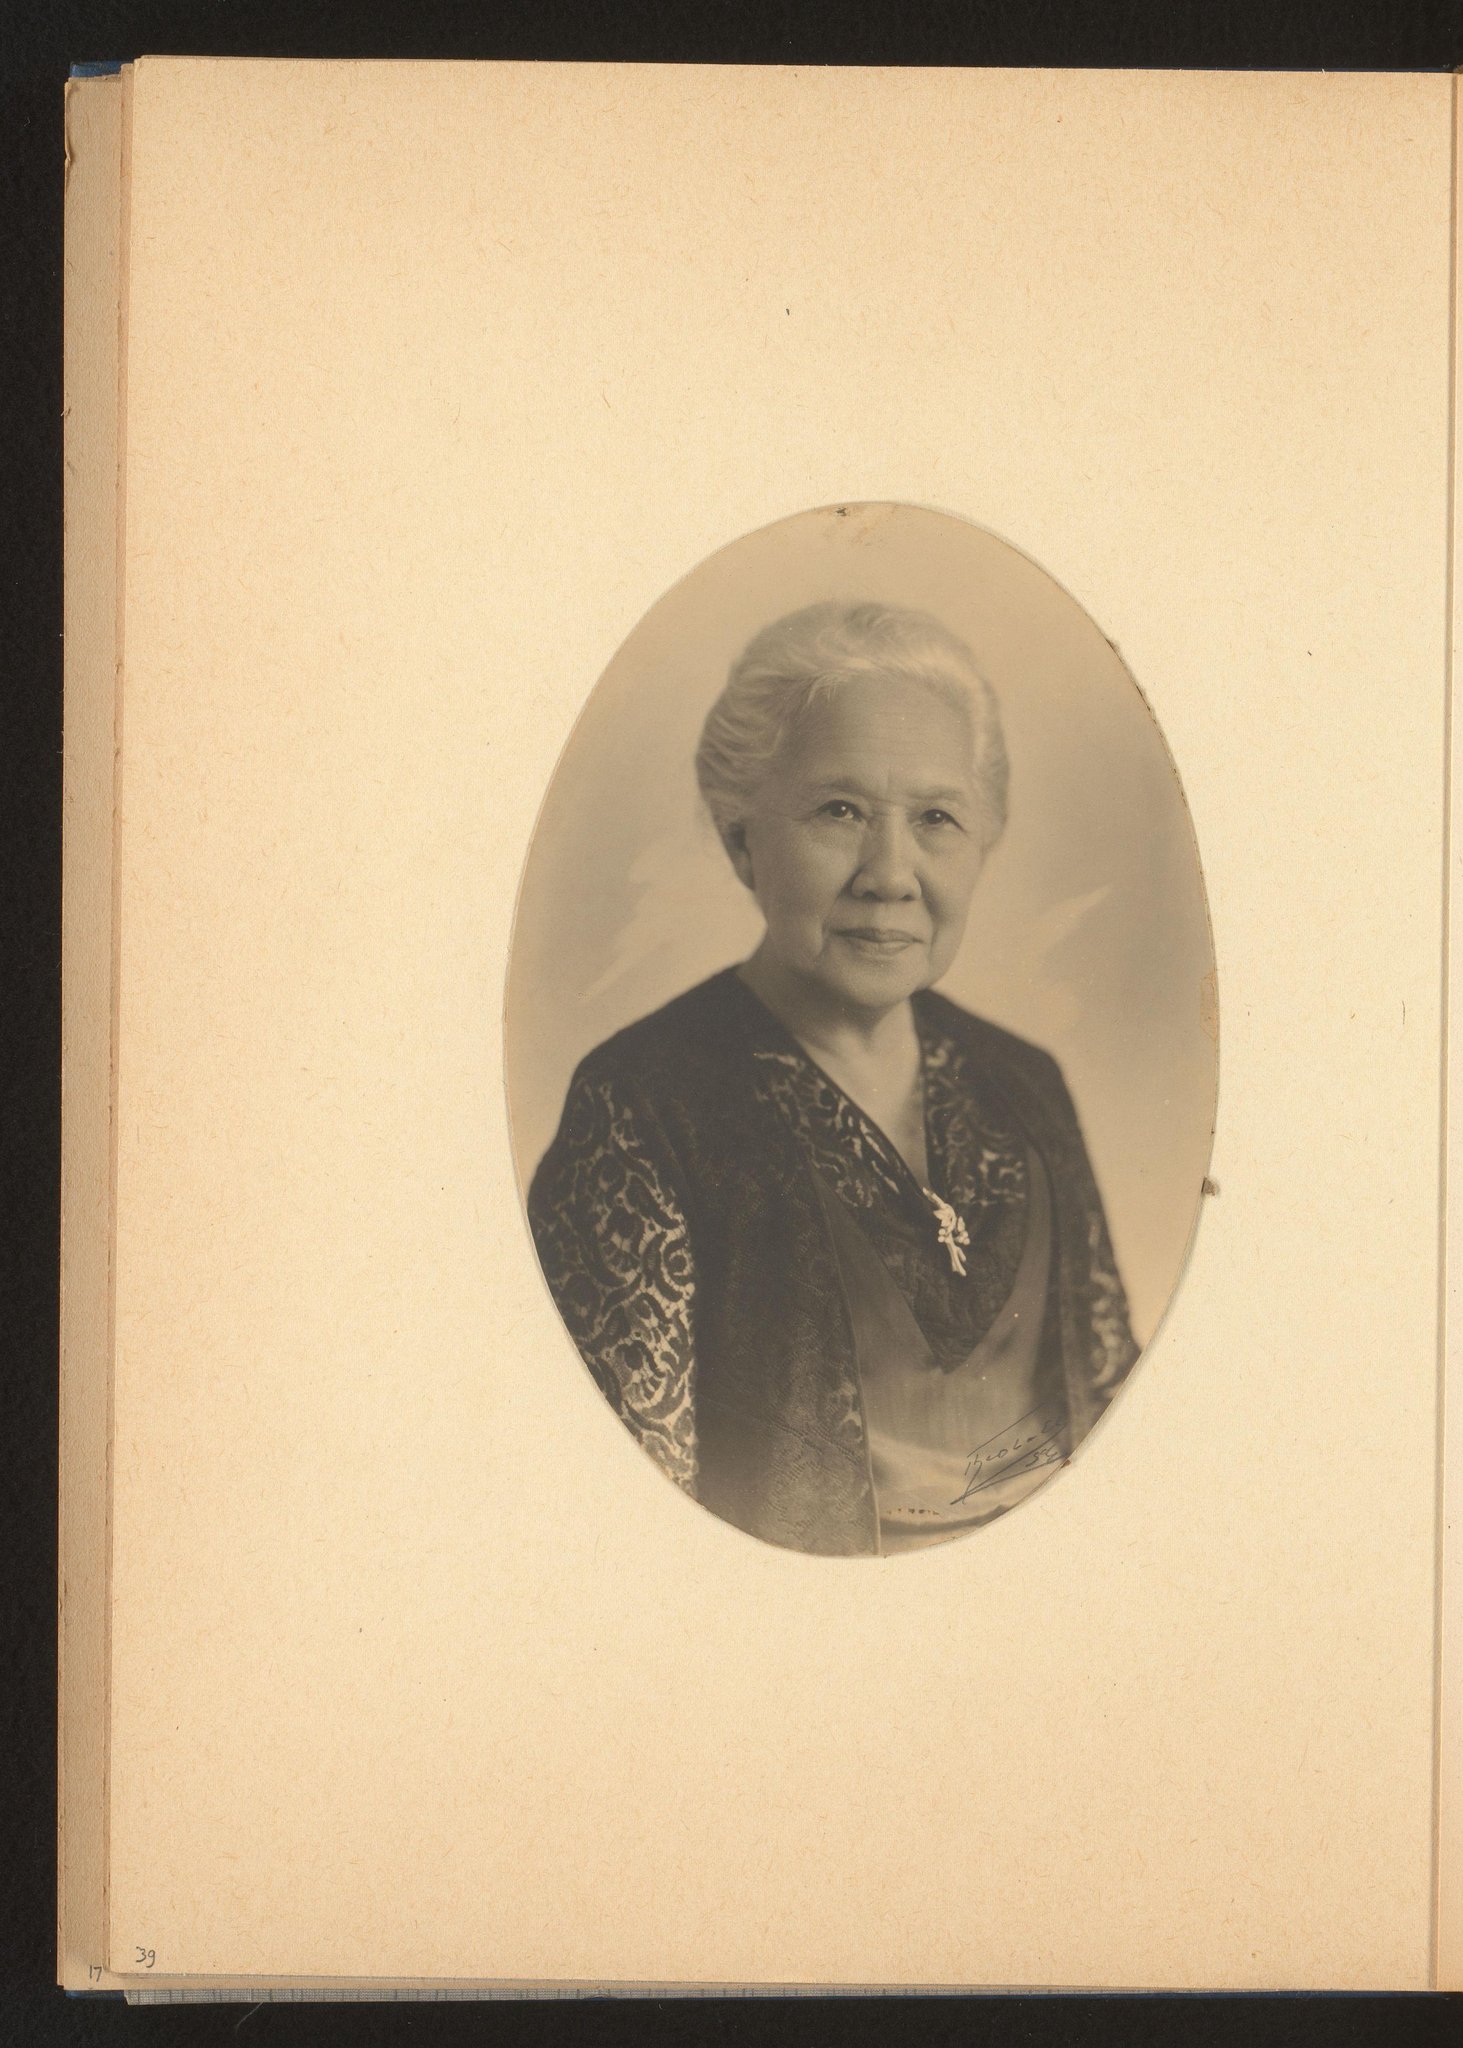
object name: album leaf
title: Grootmoeder van Eef Dumas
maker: Anonymous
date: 1880-1920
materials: cardboard, photographic support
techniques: collodion silver print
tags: surabaya, paris, beatrice jacqueline eveline dumas, historical persons - bb - woman, old woman, netherlands, dutch east indies, the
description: Blad met het portret van een oudere Indonesische vrouw, waarschijnlijk de grootmoeder van Eef Dumas. Onderdeel van het fotoalbum van Beatrice Jacqueline Eveline (Eef) Dumas, ca. 1880-1952.